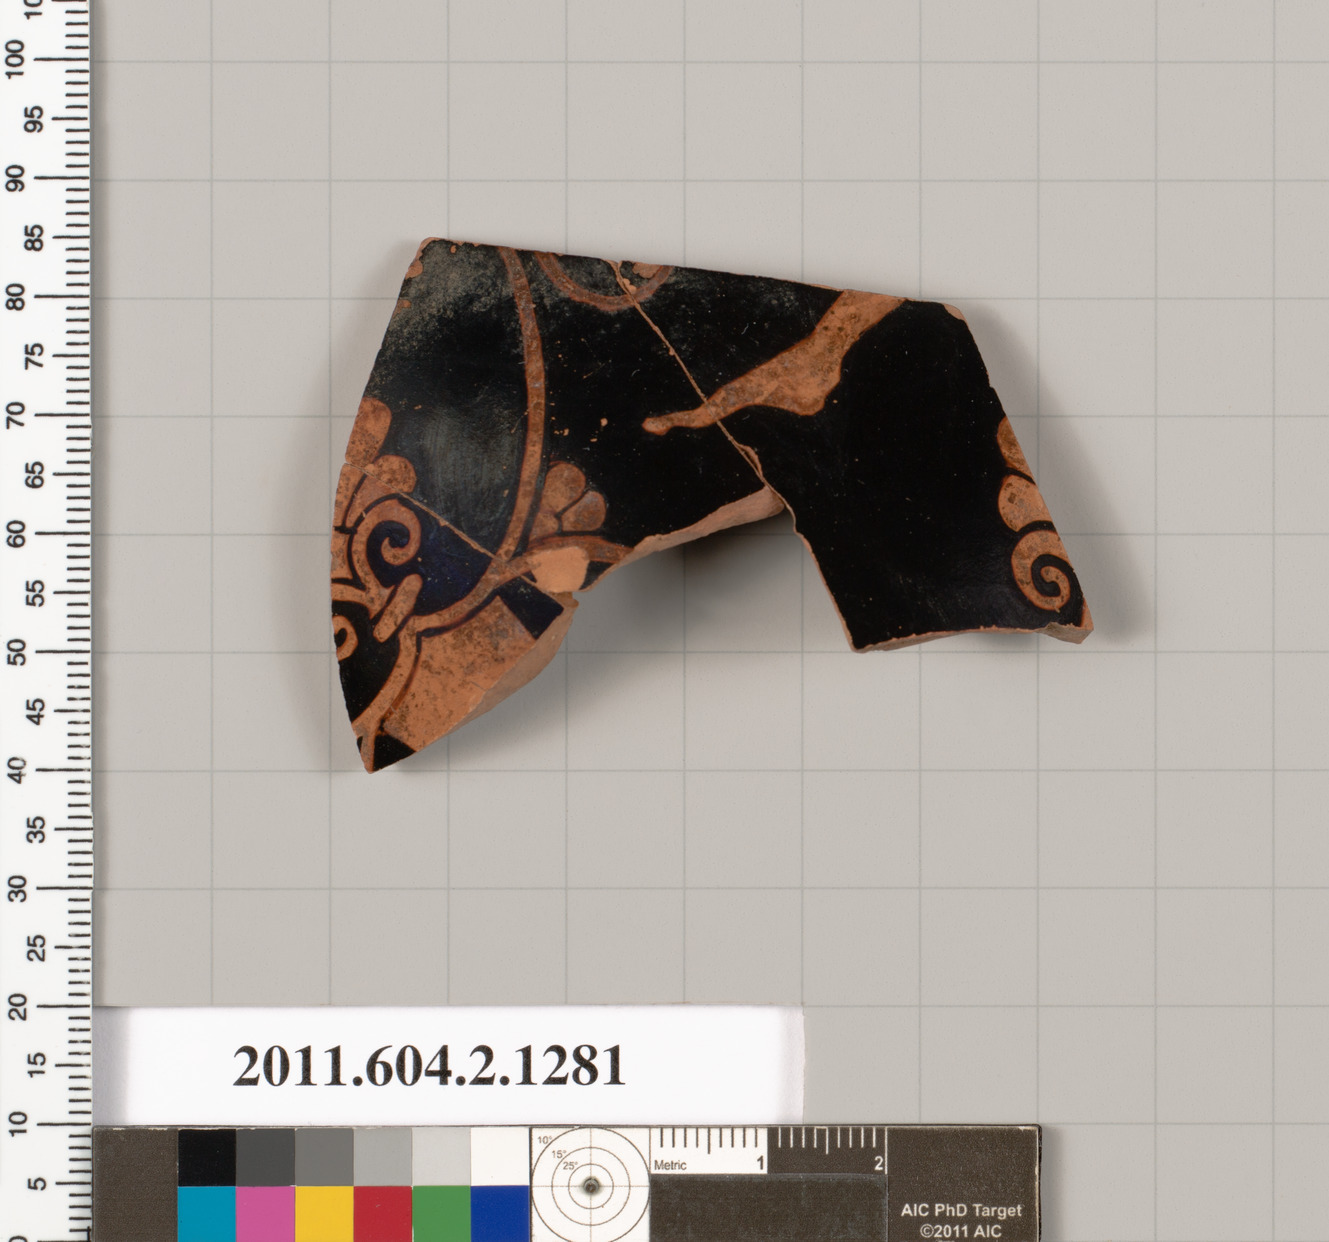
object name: skyphos fragment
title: Terracotta fragment of a skyphos (deep drinking cup)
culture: greek, attic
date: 500-480 BCE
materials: terracotta